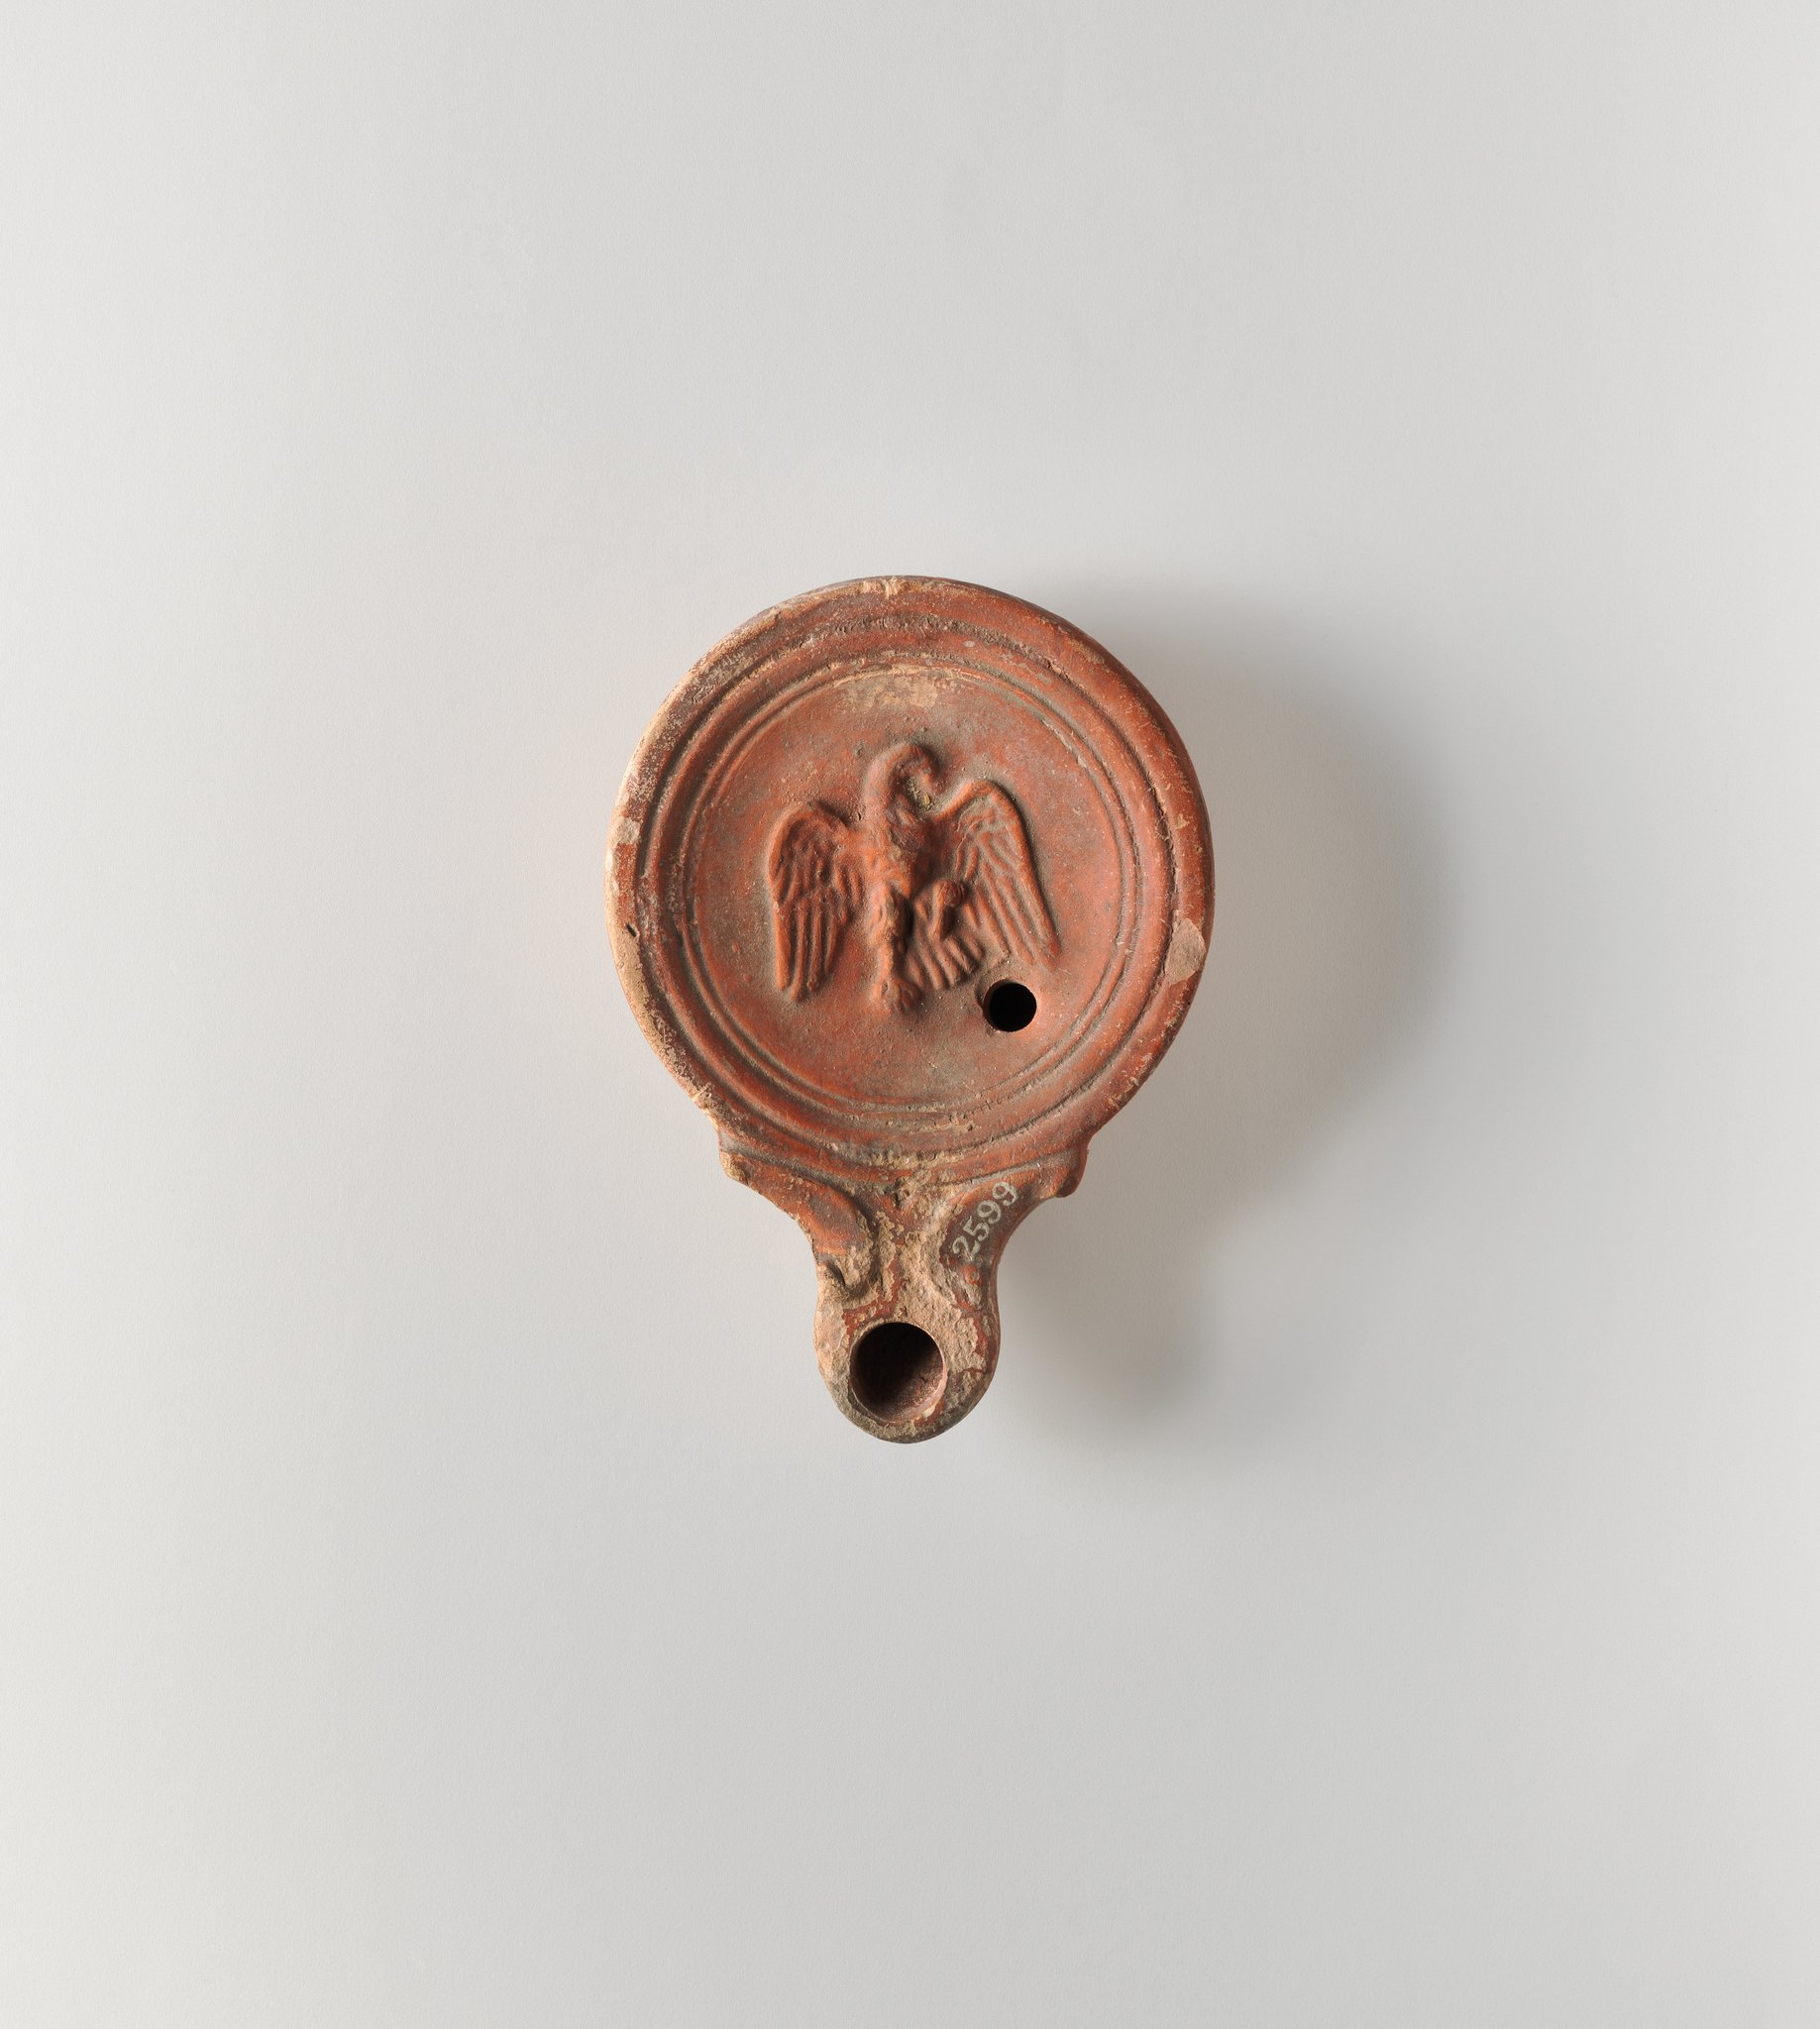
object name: lamp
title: Terracotta oil lamp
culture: roman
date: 40-100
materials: terracotta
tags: eagles